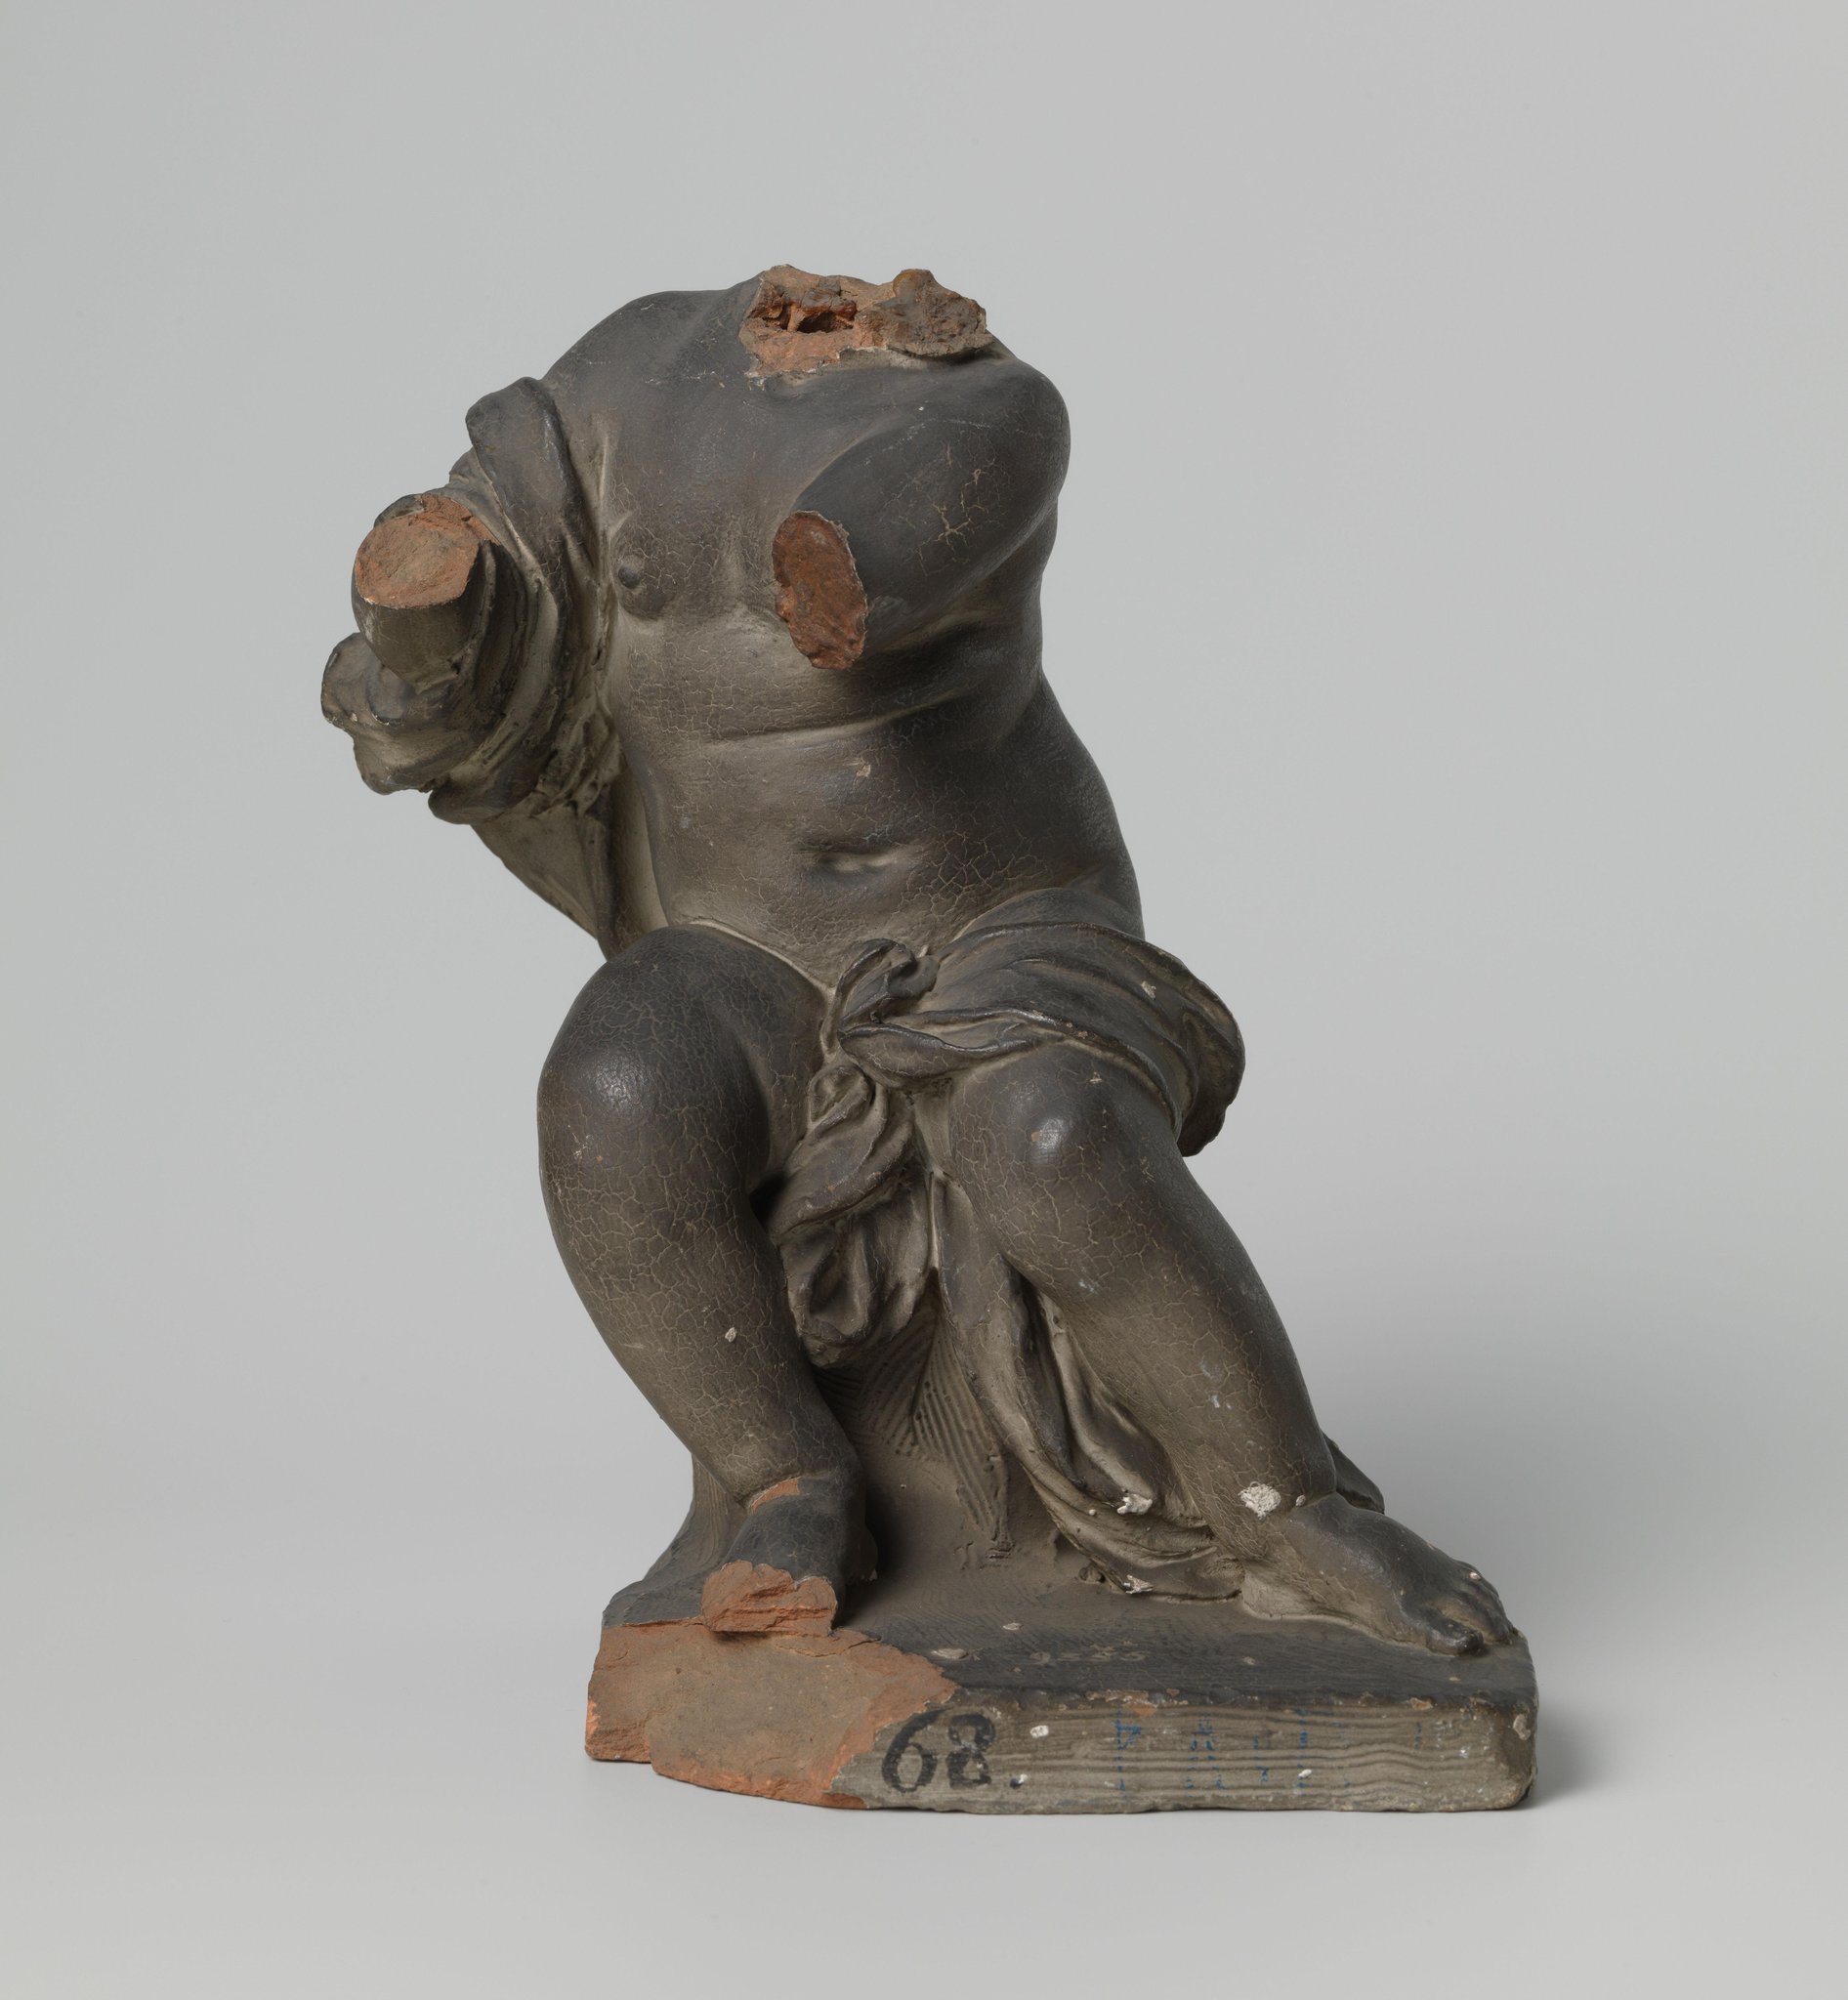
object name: sculpture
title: Seated Child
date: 1700-1750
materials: terracotta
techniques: modeling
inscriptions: number, on the front side of the plinth, in black paint: ‘68’